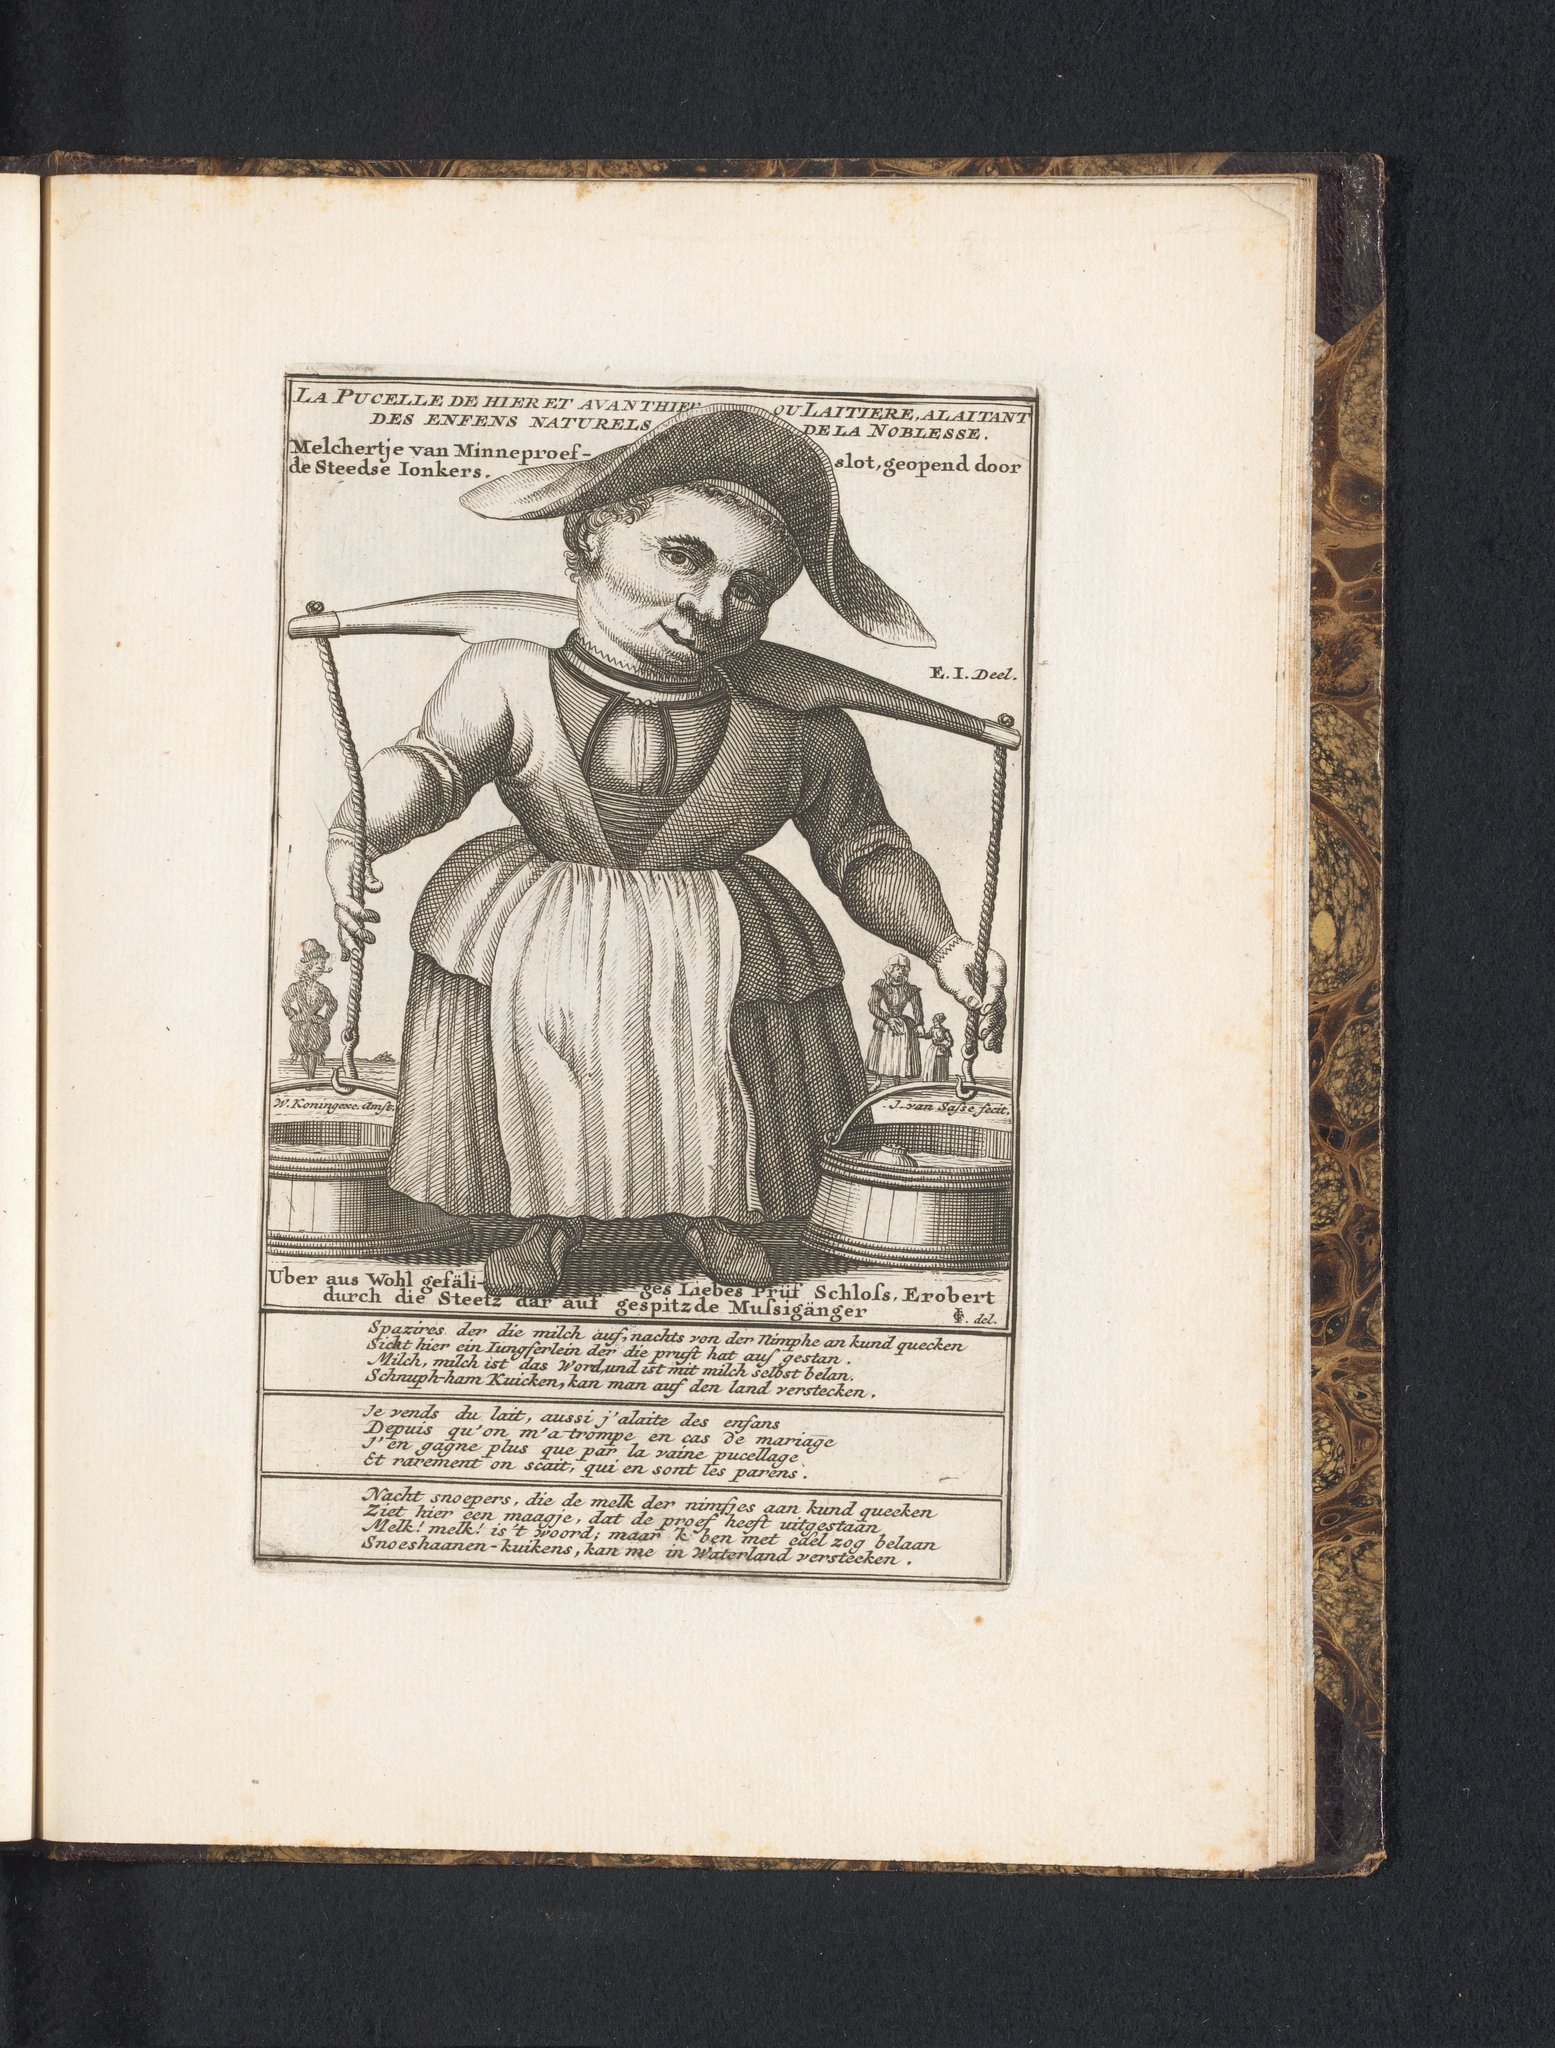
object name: print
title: Bombario Actionist en de Geest van Esopus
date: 1718-1720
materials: paper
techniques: engraving, etching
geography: northern netherlands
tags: caricatures (human types), little people, wet-nurse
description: De kleine mens Melchertje van Minneproefslot, als een min met een juk met twee emmers melk. In het onderschrift verzen in het Duits, Frans en Nederlands. Genummerd: E. 1 Deel. Onderdeel van de tweede Nederlandse gebonden uitgave uit 1720 (en gerelateerd aan de Windhandel in dat jaar) van een serie karikaturen van kleine mensen, bekend als Het Dwergentooneel.